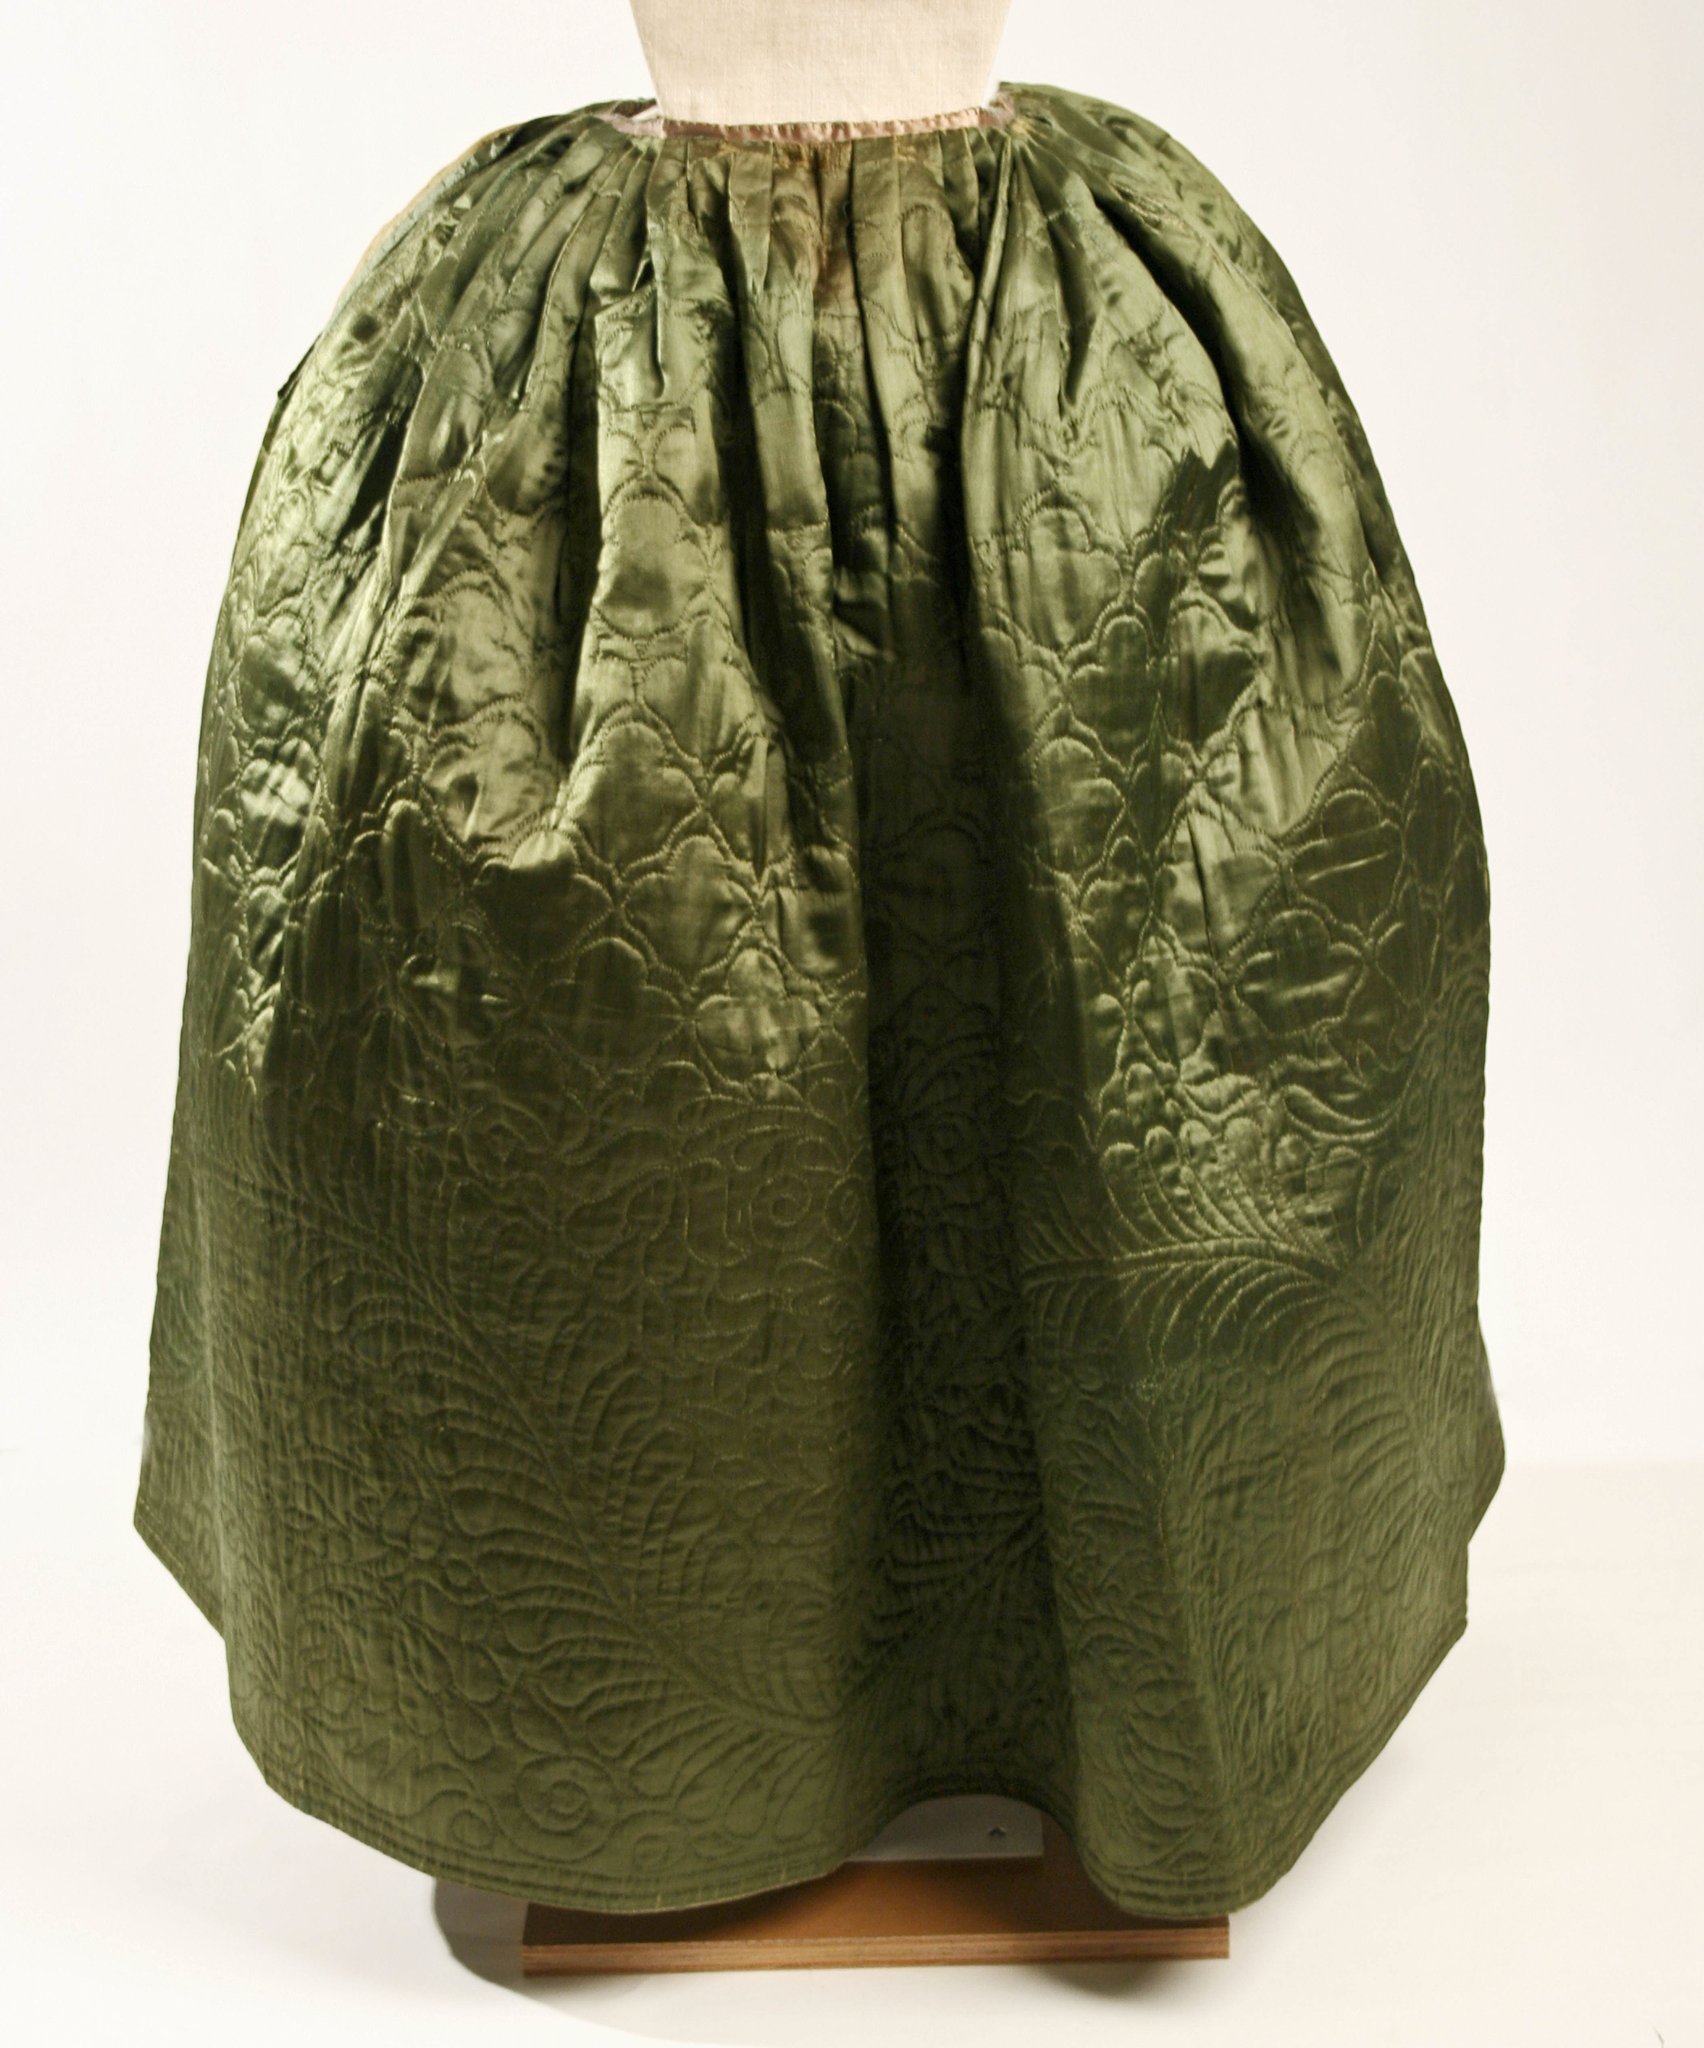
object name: petticoat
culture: american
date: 1701-1800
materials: silk